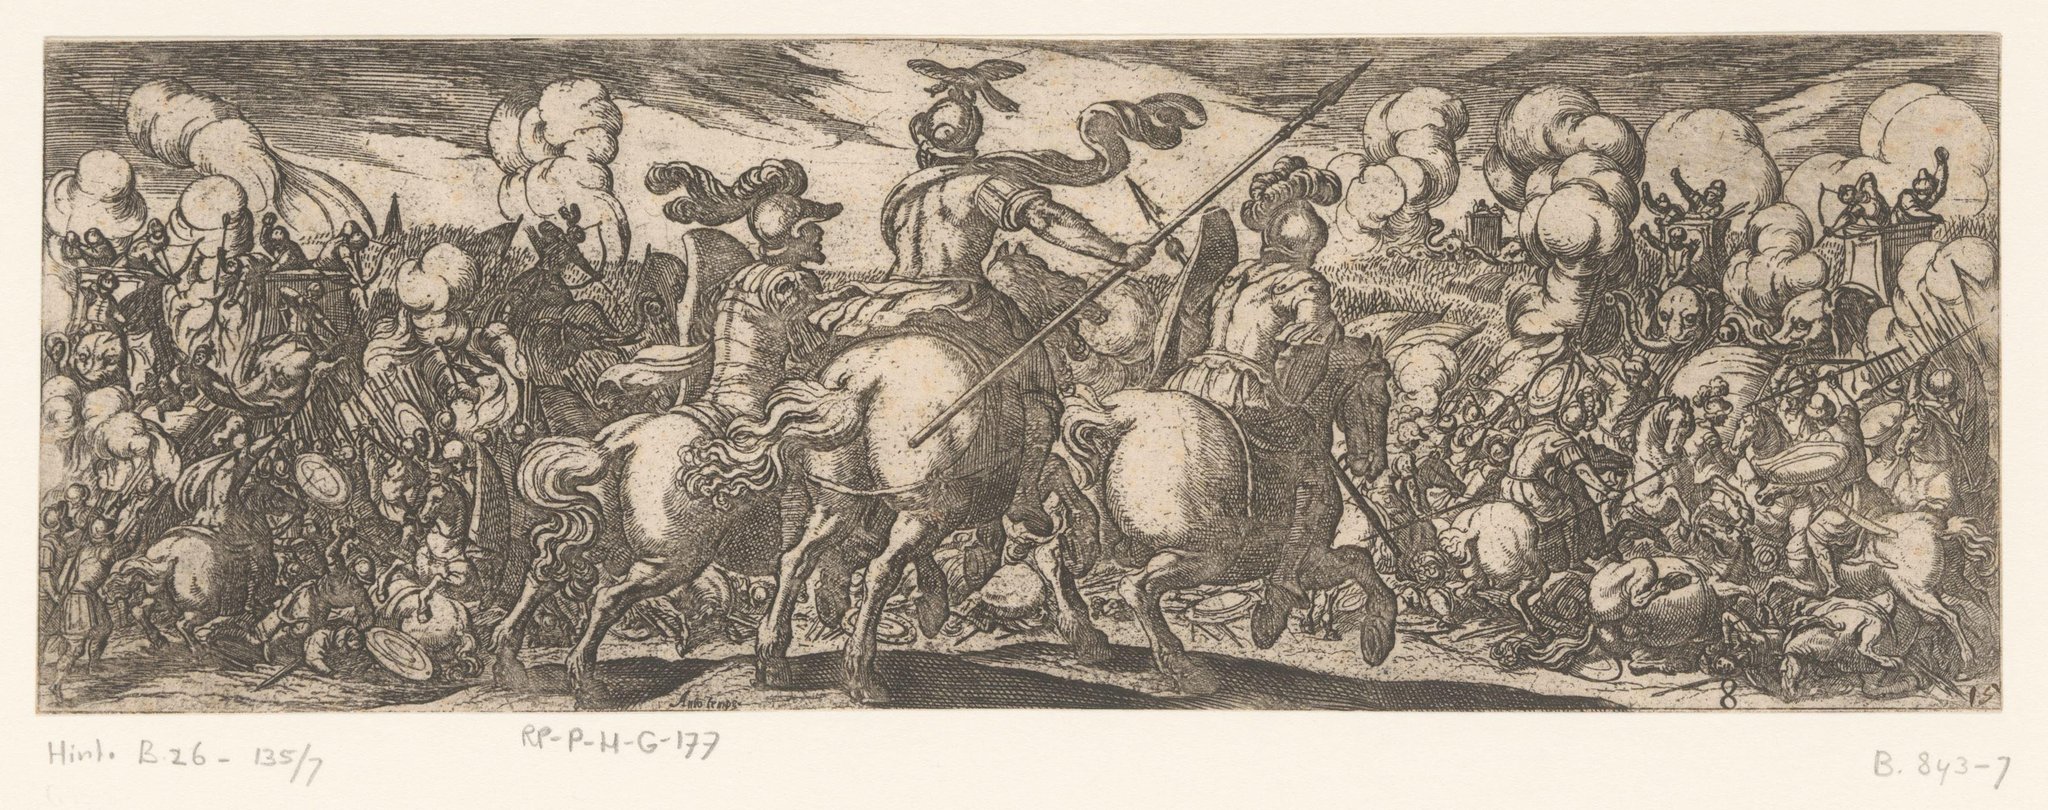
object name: print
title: Cavalerie aanval tegen een leger met olifanten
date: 1599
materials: paper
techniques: etching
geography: italy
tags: battle, warfare; military affairs (+ cavalry, horsemen), the soldier; the soldier's life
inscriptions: number: ‘15’, collector's mark: ‘Hinloopen’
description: Deze prent maakt deel uit van een reeks van 9 prenten (+ titelprent) met gevechtsscènes. Antonio Tempesta maakte ook een eerdere serie met gevechtsscènes van 10 prenten (+titelprent).